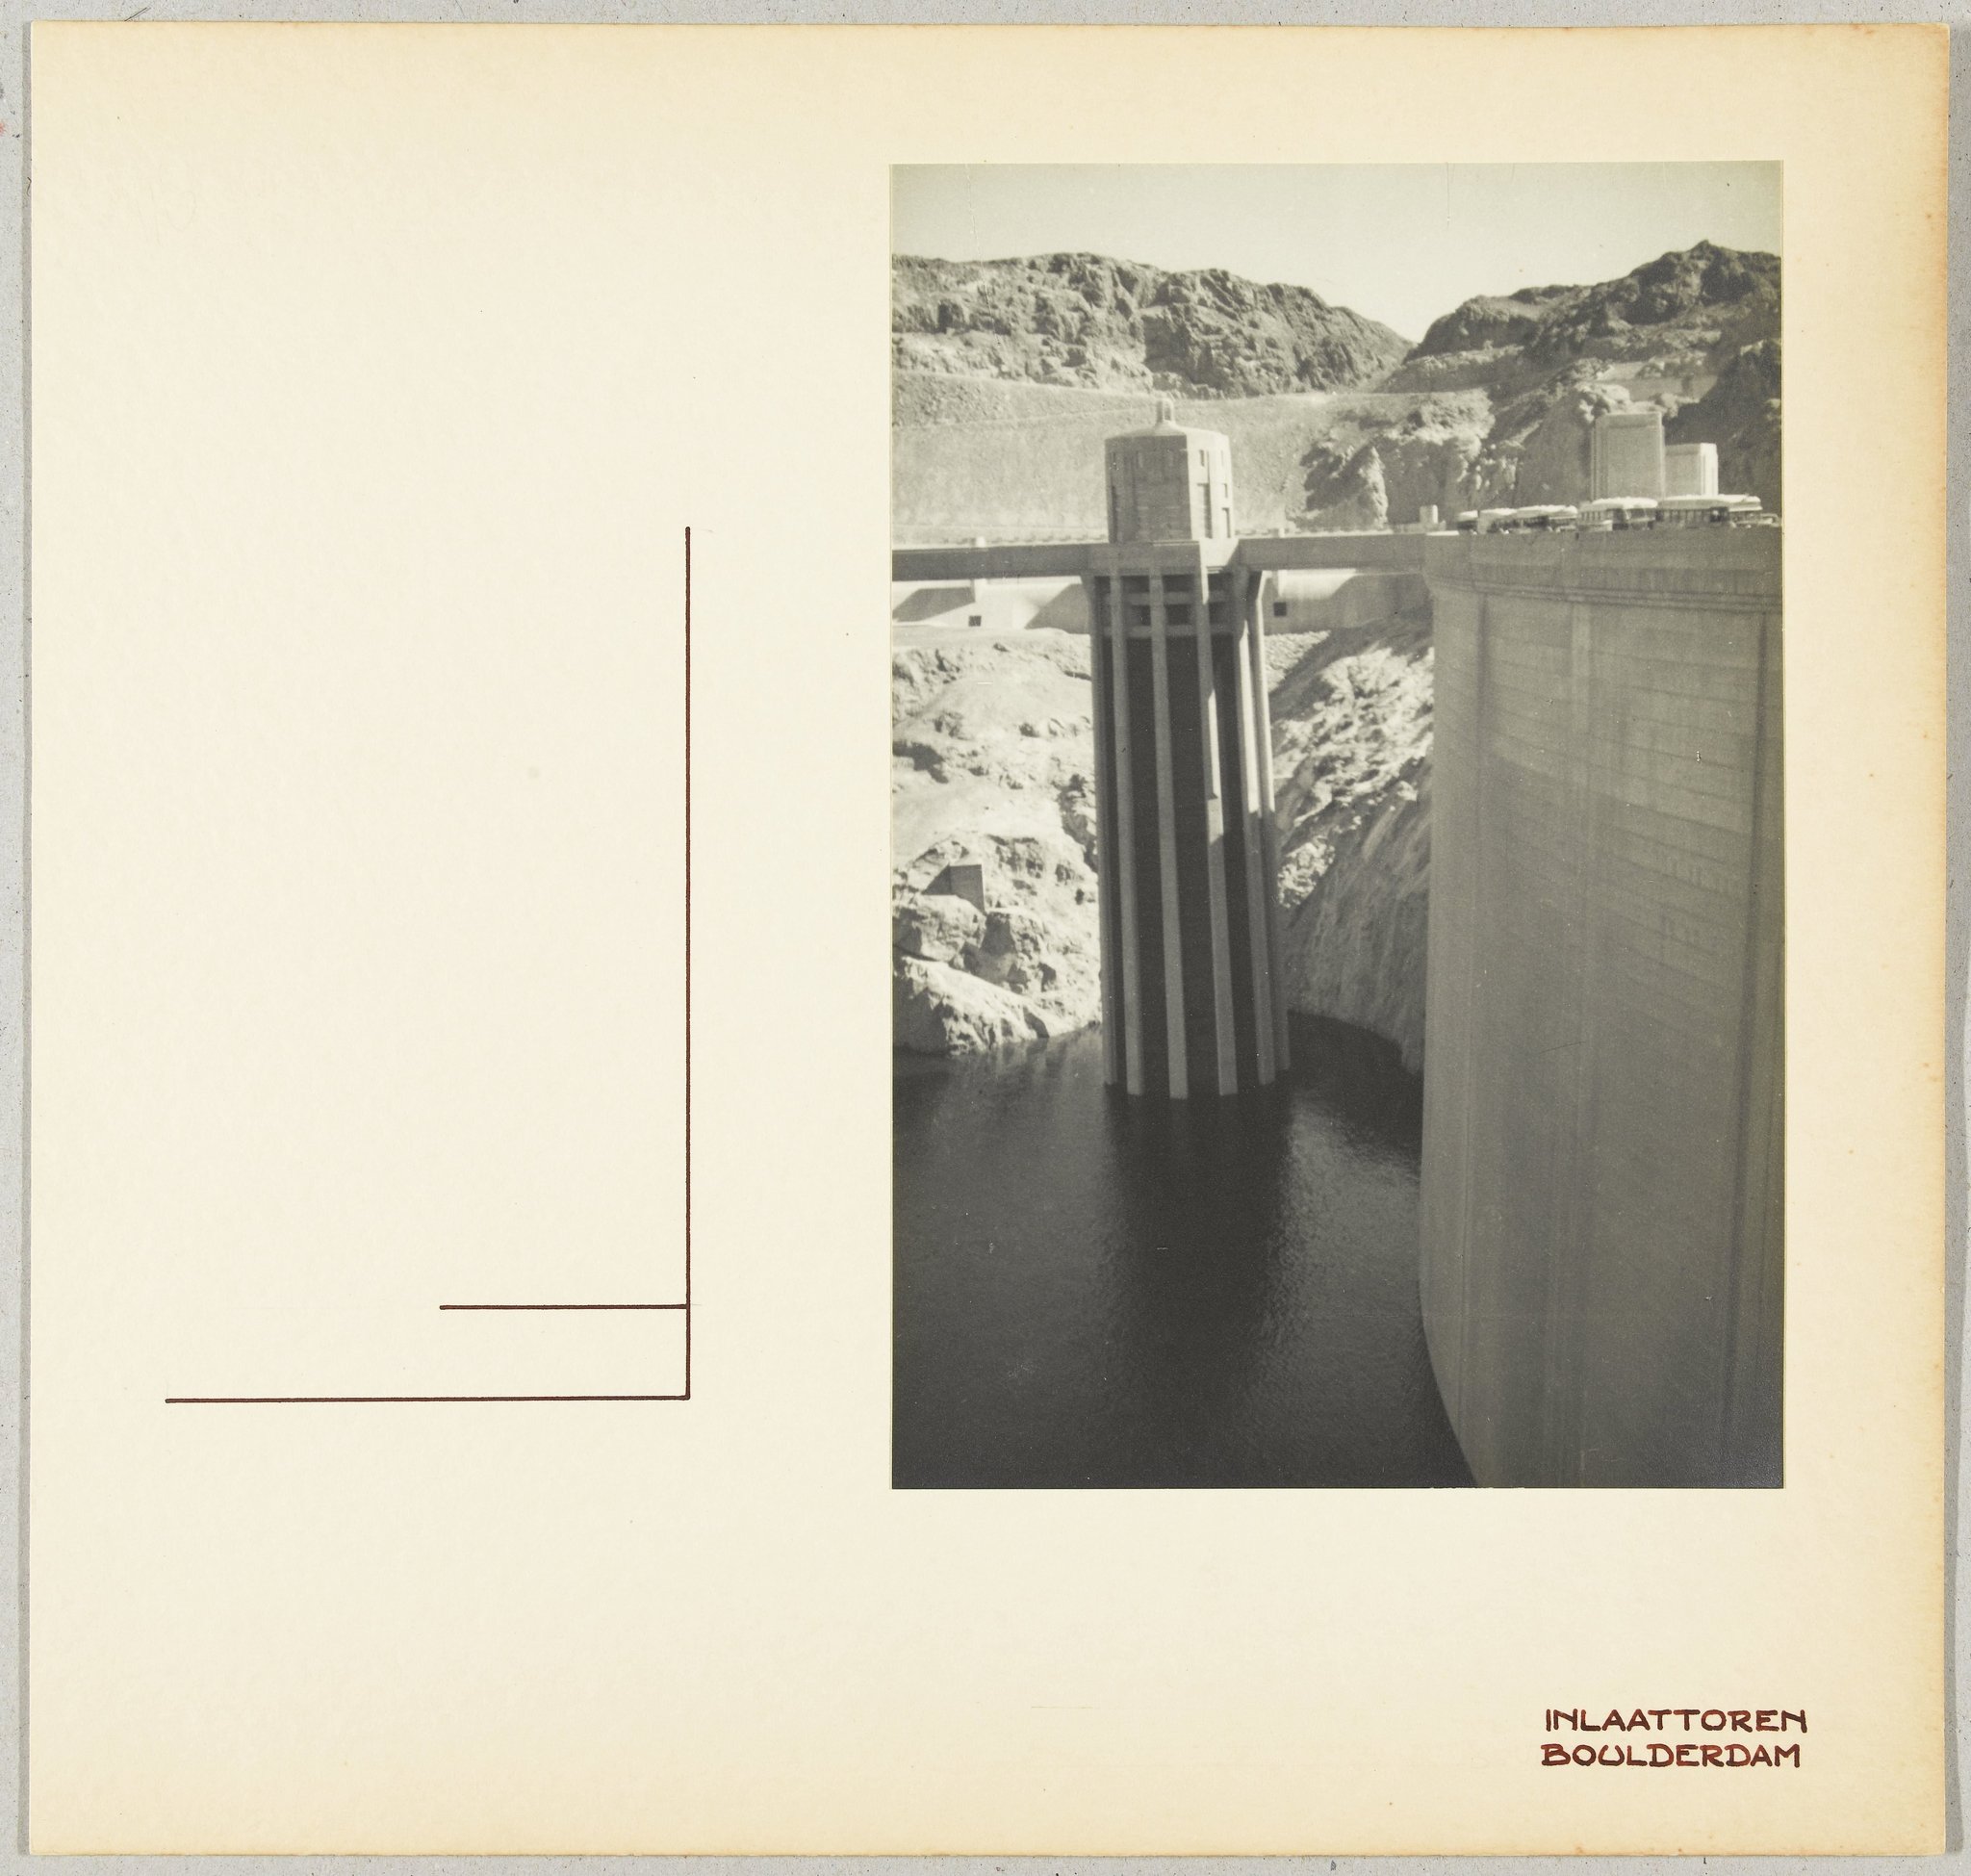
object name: photograph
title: Boulder Dam, Arizona/Nevada, Verenigde Staten: inlaattoren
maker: wouter cool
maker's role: engineer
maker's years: 1877-1947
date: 1936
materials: cardboard, paper, photographic support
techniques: gelatin silver print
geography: united states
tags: dam (in canal)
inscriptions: title: ‘INLAATTOREN / BOULDERDAM’